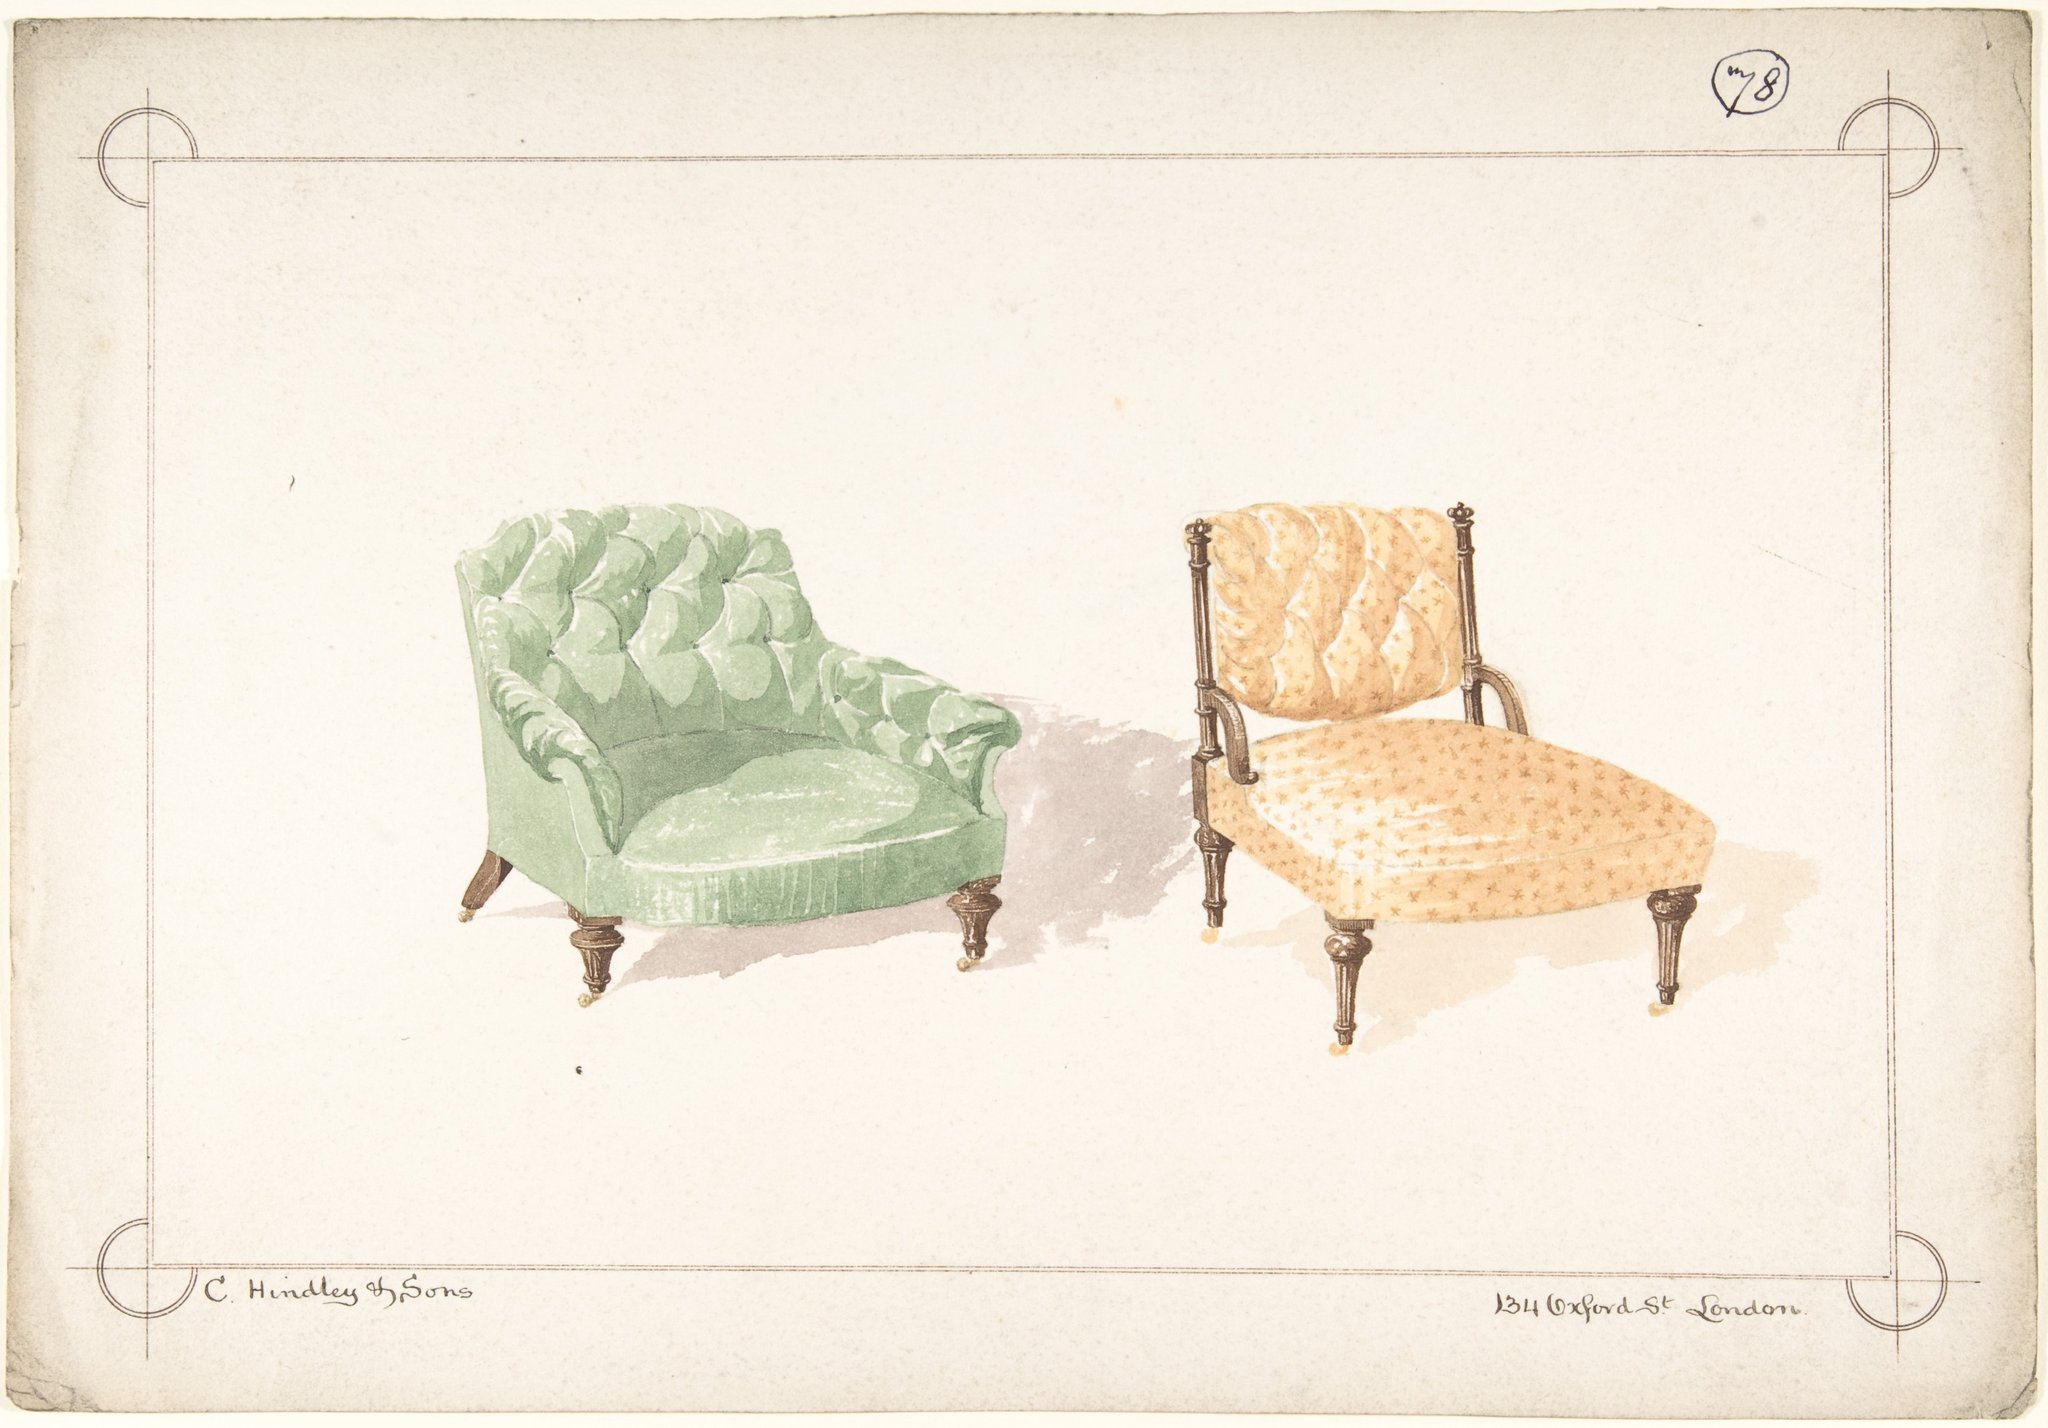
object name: drawing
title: Designs for Two Chairs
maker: charles hindley and sons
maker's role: artist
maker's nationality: british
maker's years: 1841-1917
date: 1841-1884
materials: graphite, watercolor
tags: chairs